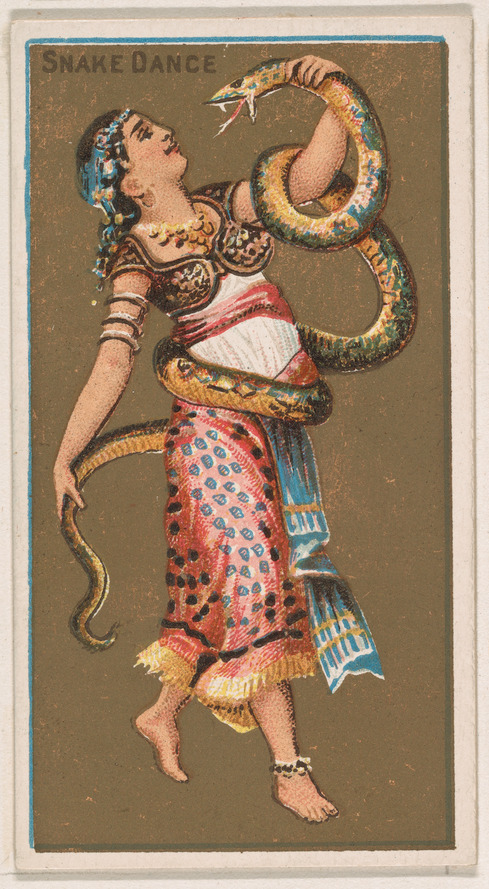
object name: print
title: Snake Dance, from National Dances (N225, Type 1) issued by Kinney Bros.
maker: kinney brothers tobacco company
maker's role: publisher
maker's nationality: american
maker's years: 1869-2011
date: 1889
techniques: color lithograph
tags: profiles,women,dancing,snakes,dancers